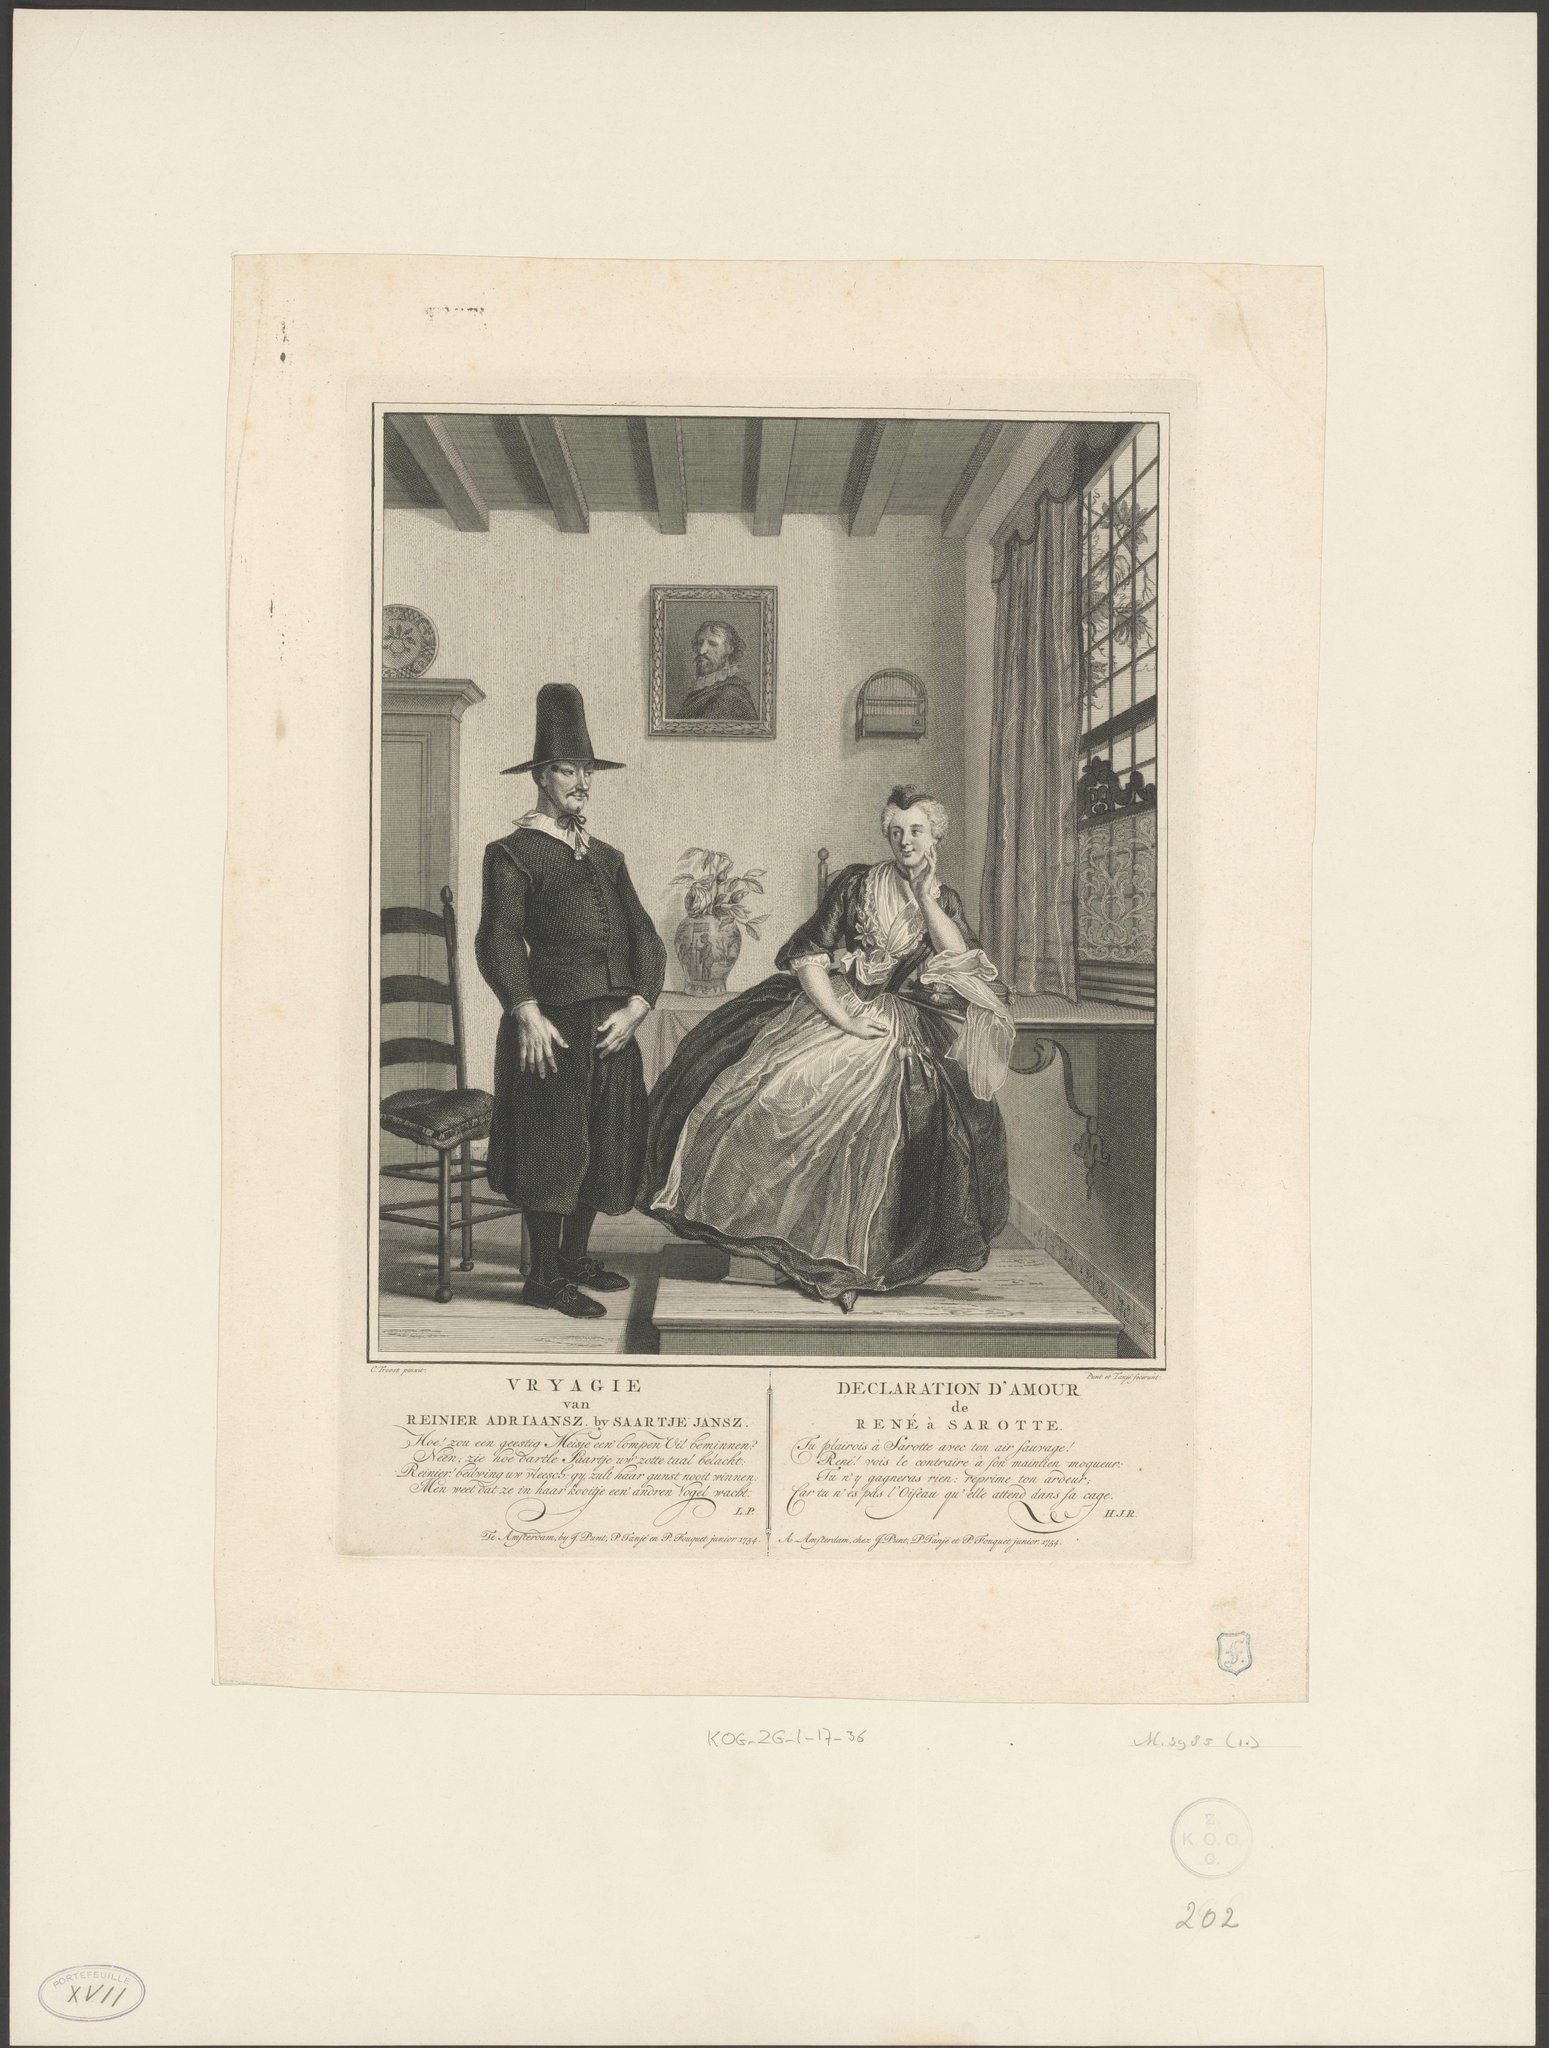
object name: print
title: Jan Claasz of de gewaande dienstmaagd: de liefdesverklaring van Reinier Adriaansz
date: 1754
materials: paper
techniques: engraving, etching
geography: amsterdam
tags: being refused, the proposal rejected, living-room, parlour, sitting-room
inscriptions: collector's mark: Lugt 1641, stamp, collector's mark: Lugt 963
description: Reinier Adriaansz verklaart Saartje Jansz. in een huiskamer zijn liefde. Saartje Jansz wijst hem echter af. Onderaan in de marge een vierregelig vers in het Nederlands en het Frans. Scène uit het toneelstuk Jan Claasz of de gewaande dienstmaagd, van Thomas Asselyn. Onderwerpsrubrieken binnen de Atlas Zeden en Gewoonten: Tooneel, Prenten van Cornelis Troost.